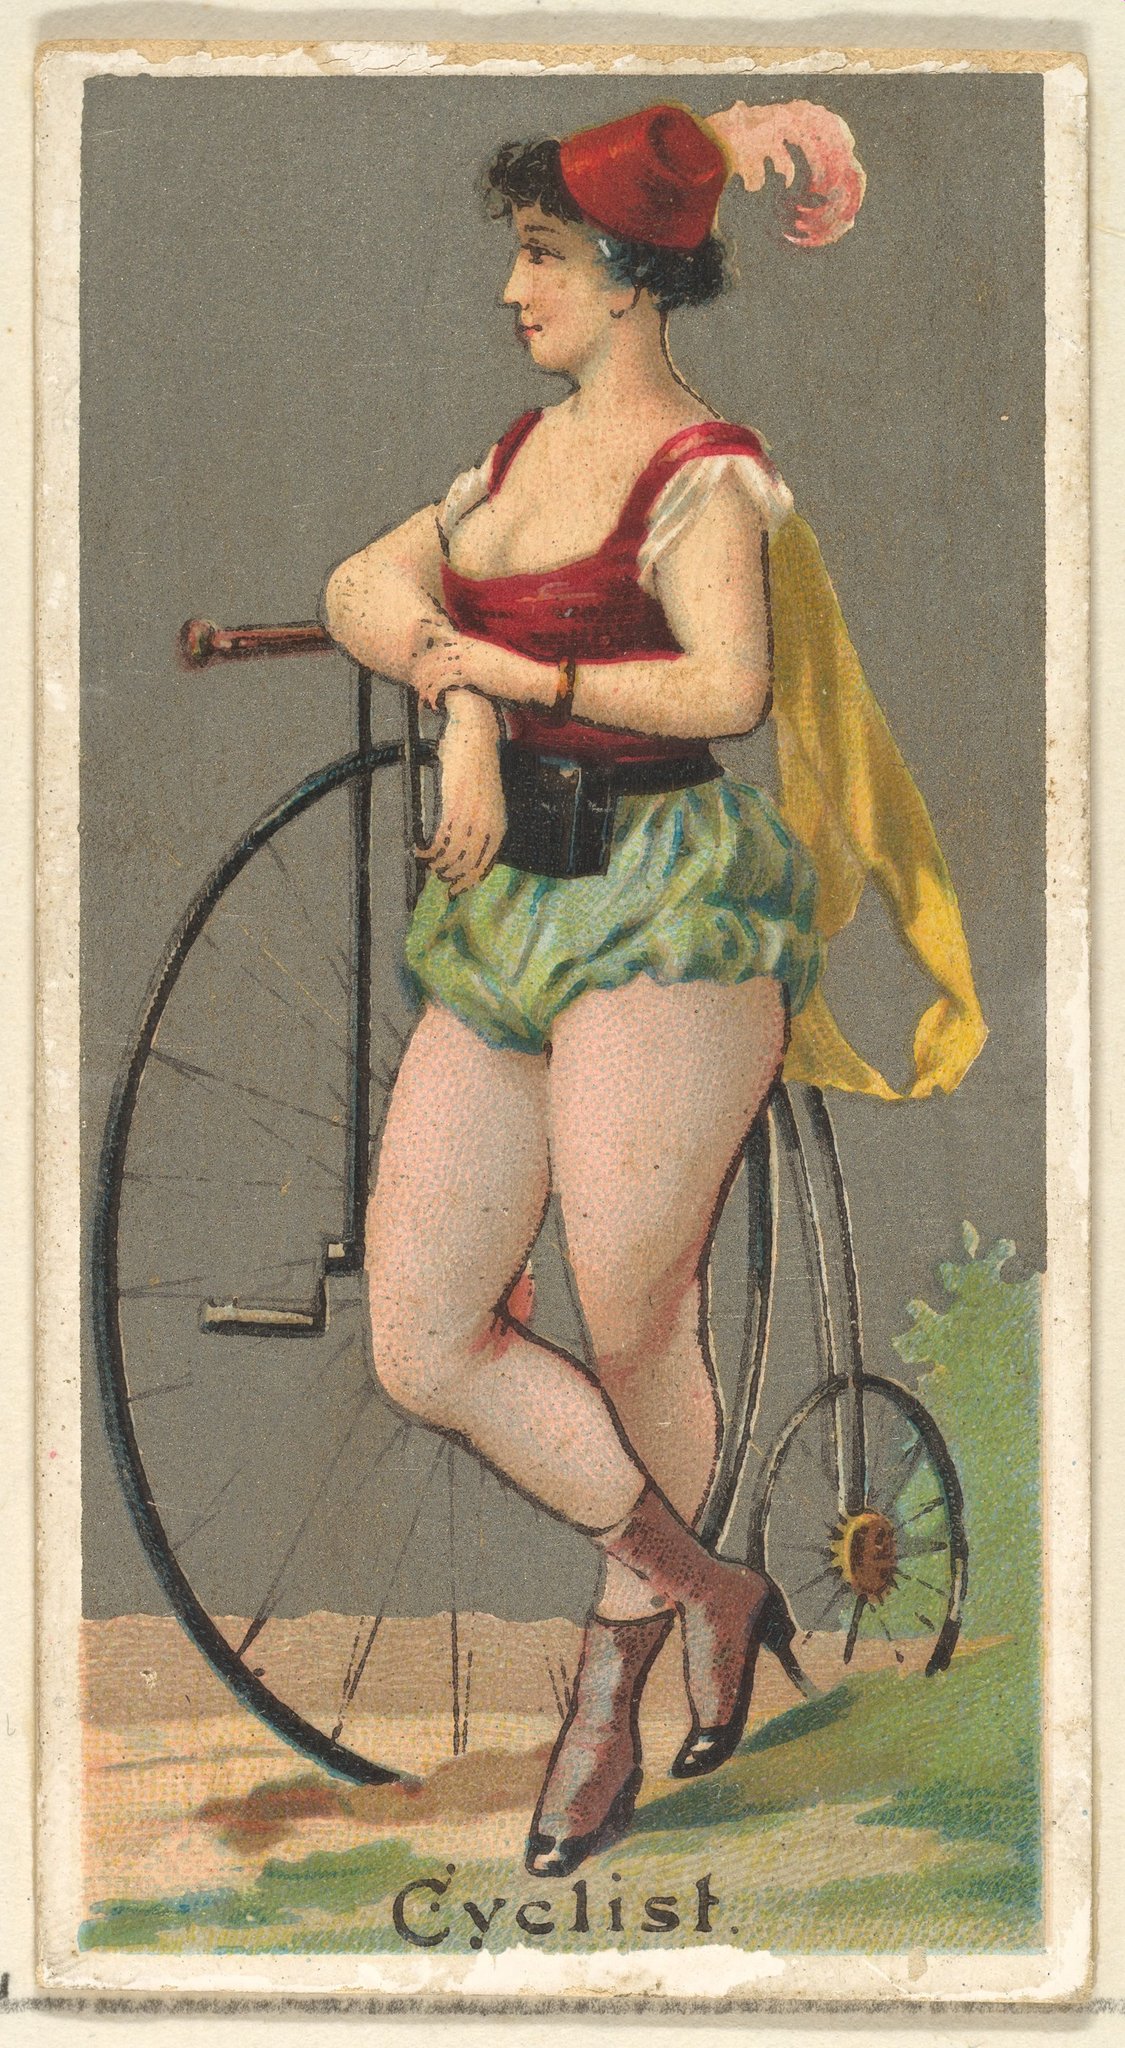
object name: print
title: Cyclist, from the Occupations for Women series (N166) for Old Judge and Dogs Head Cigarettes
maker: goodwin & company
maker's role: publisher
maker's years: 1850-1950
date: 1887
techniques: color lithograph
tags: women,athletes,bicycles